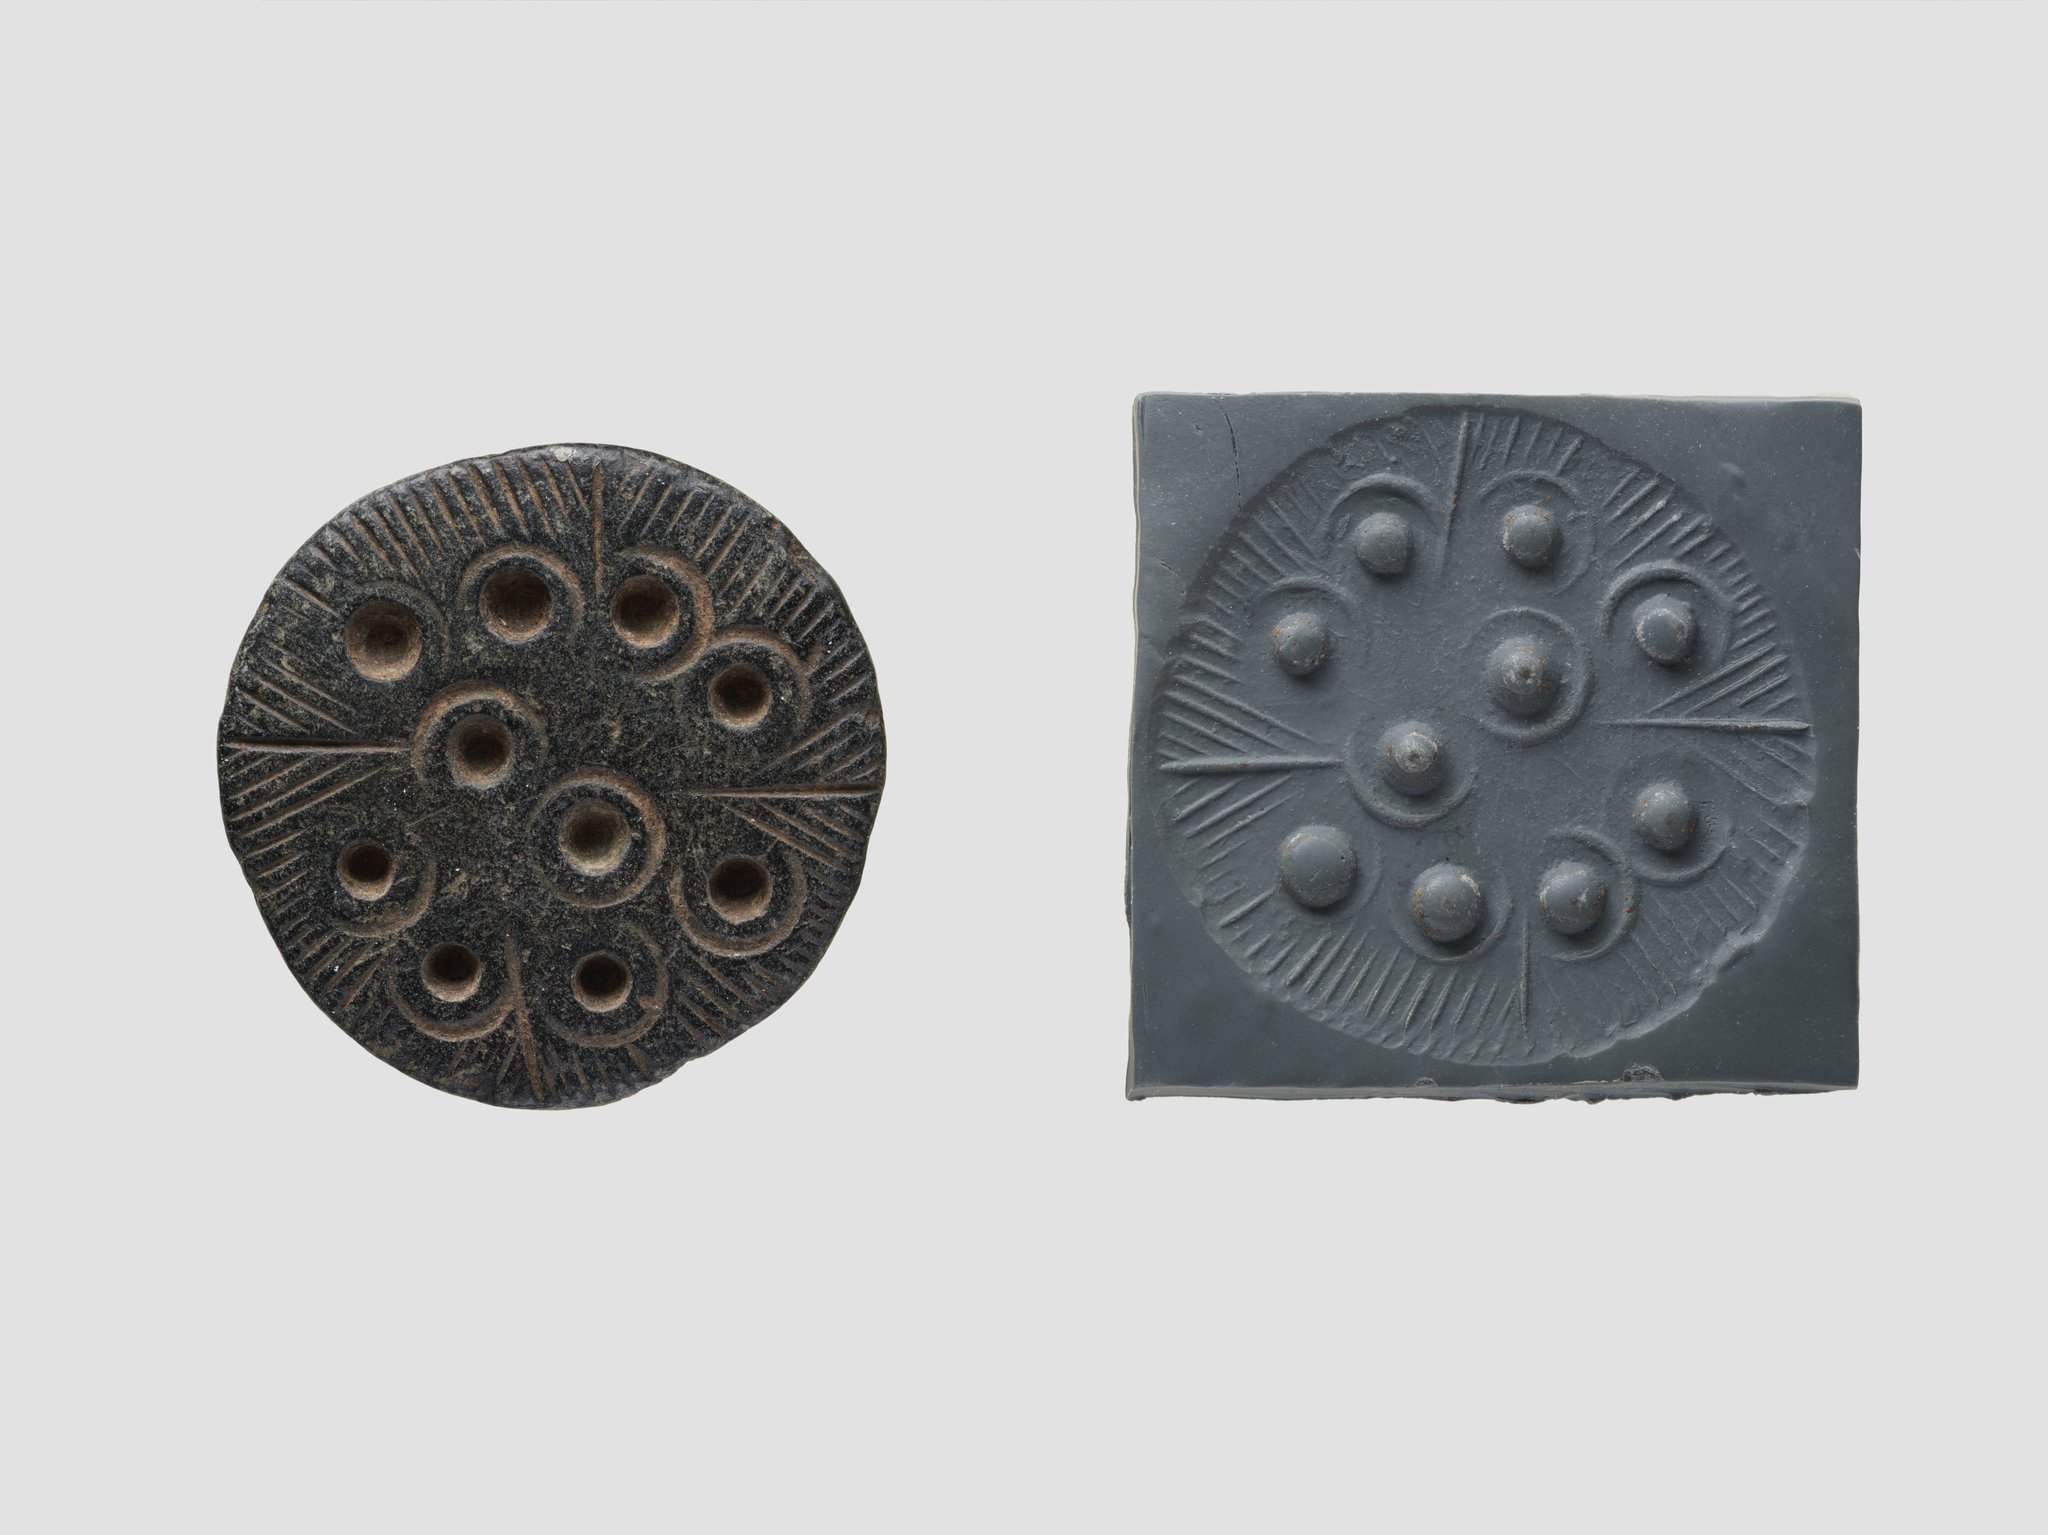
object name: stamp seal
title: Loop-handled circular seal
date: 5000-3001 BCE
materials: mineral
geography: northern syria or northern mesopotamia